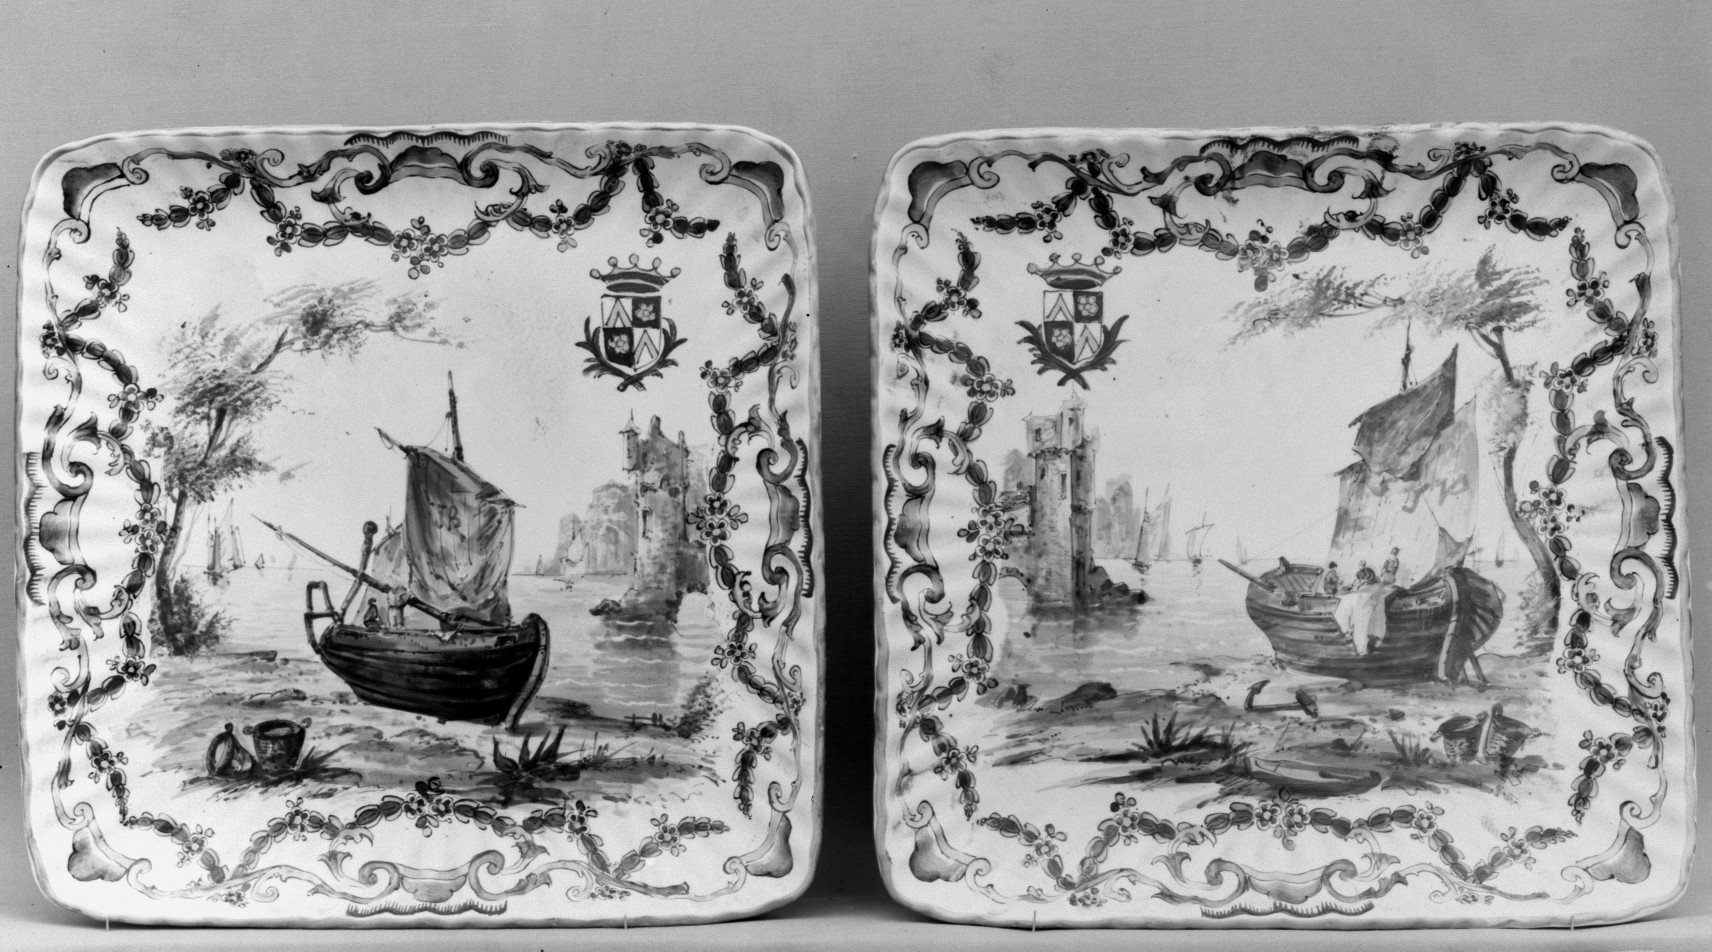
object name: tray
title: Pair of trays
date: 1801-1900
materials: faience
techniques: glazing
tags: ships